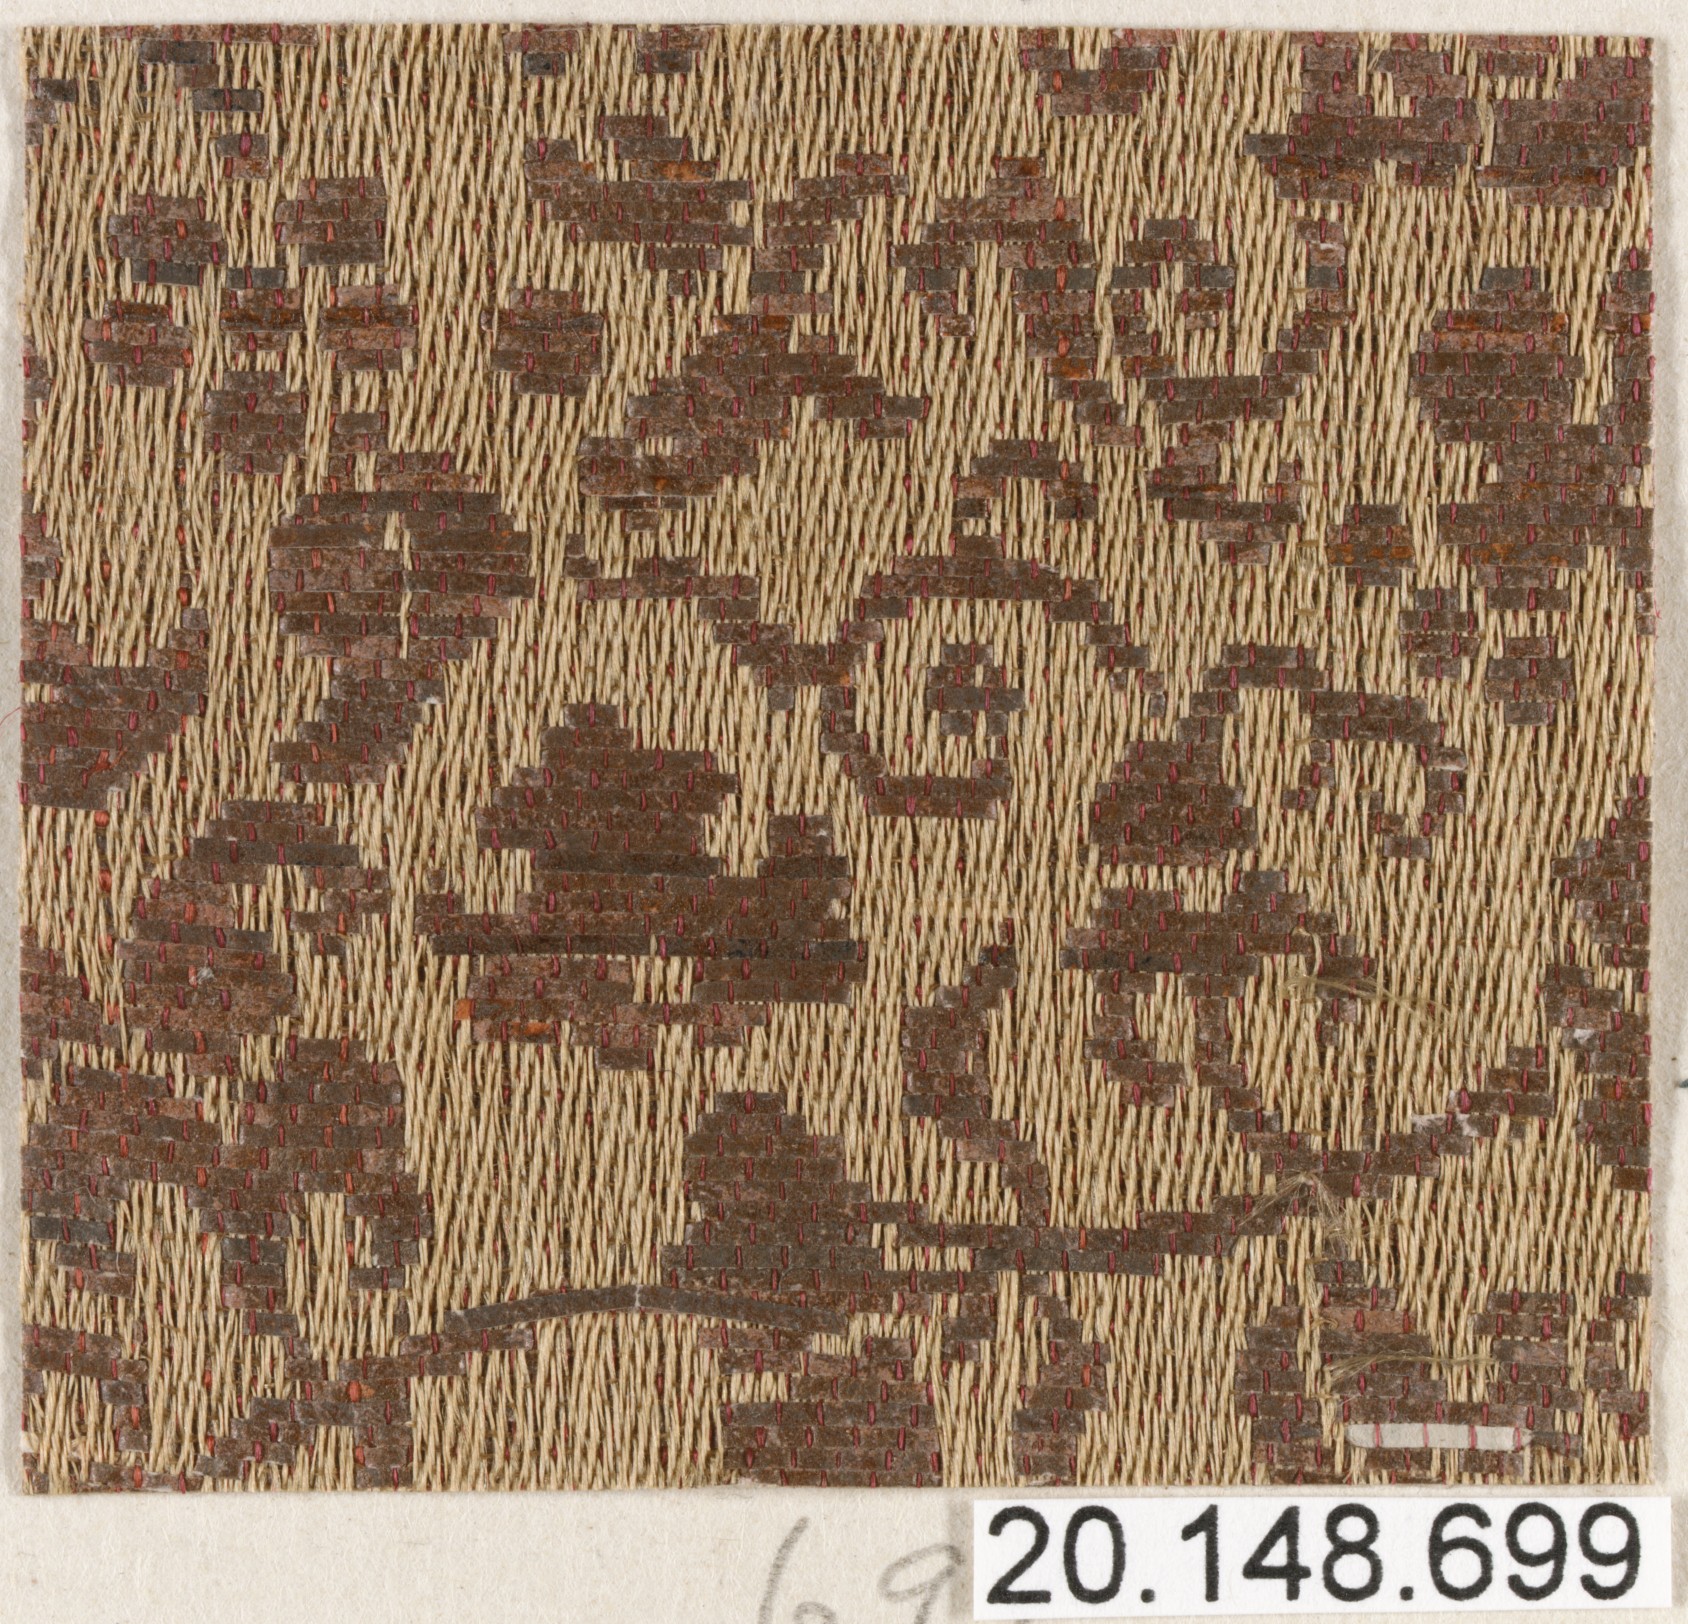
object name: piece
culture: japanese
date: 1601-1700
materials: silk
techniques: compound weave